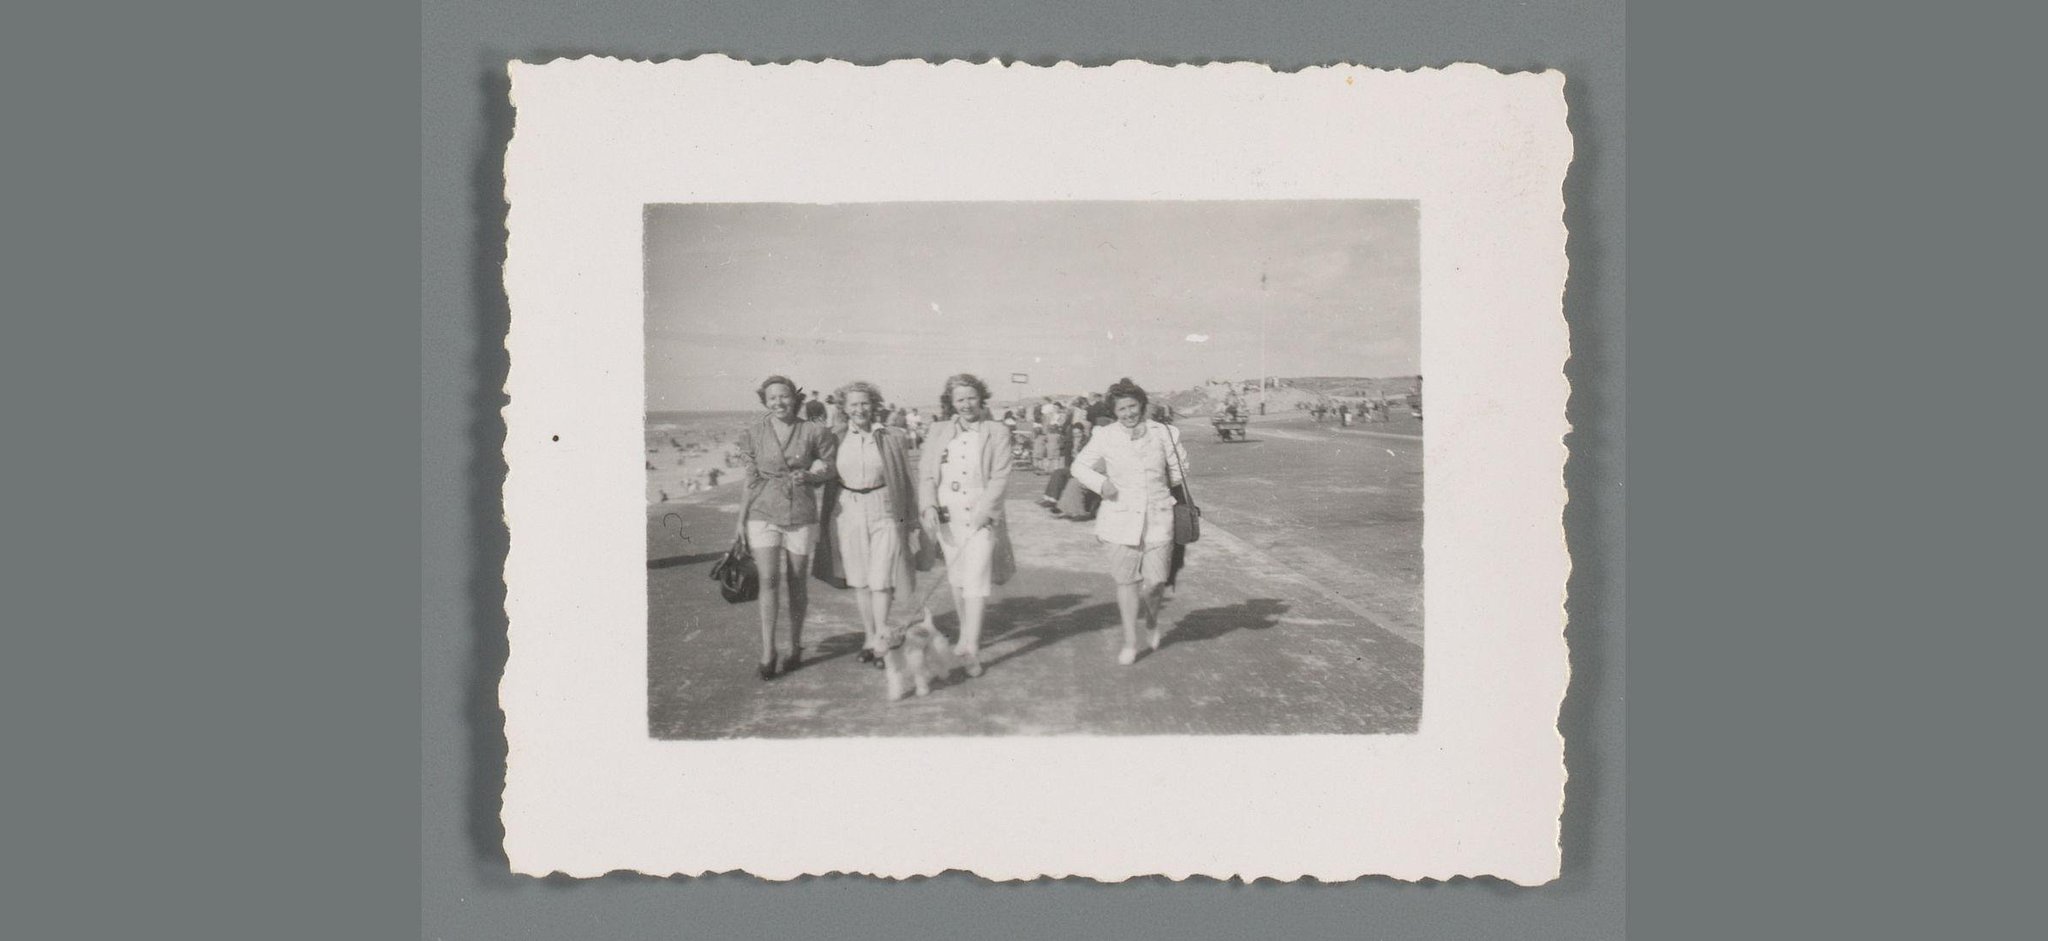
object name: photograph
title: Groepsportret van vier onbekende vrouwen lopend langs het strand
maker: Anonymous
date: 1946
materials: paper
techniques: gelatin silver print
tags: beach (as place of recreation), strolling, anonymous historical persons portrayed in a group, in a group-portrait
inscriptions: inscription: ‘VB2’, inscription: ‘Aan Katinka/ van Zulma/ 1946’